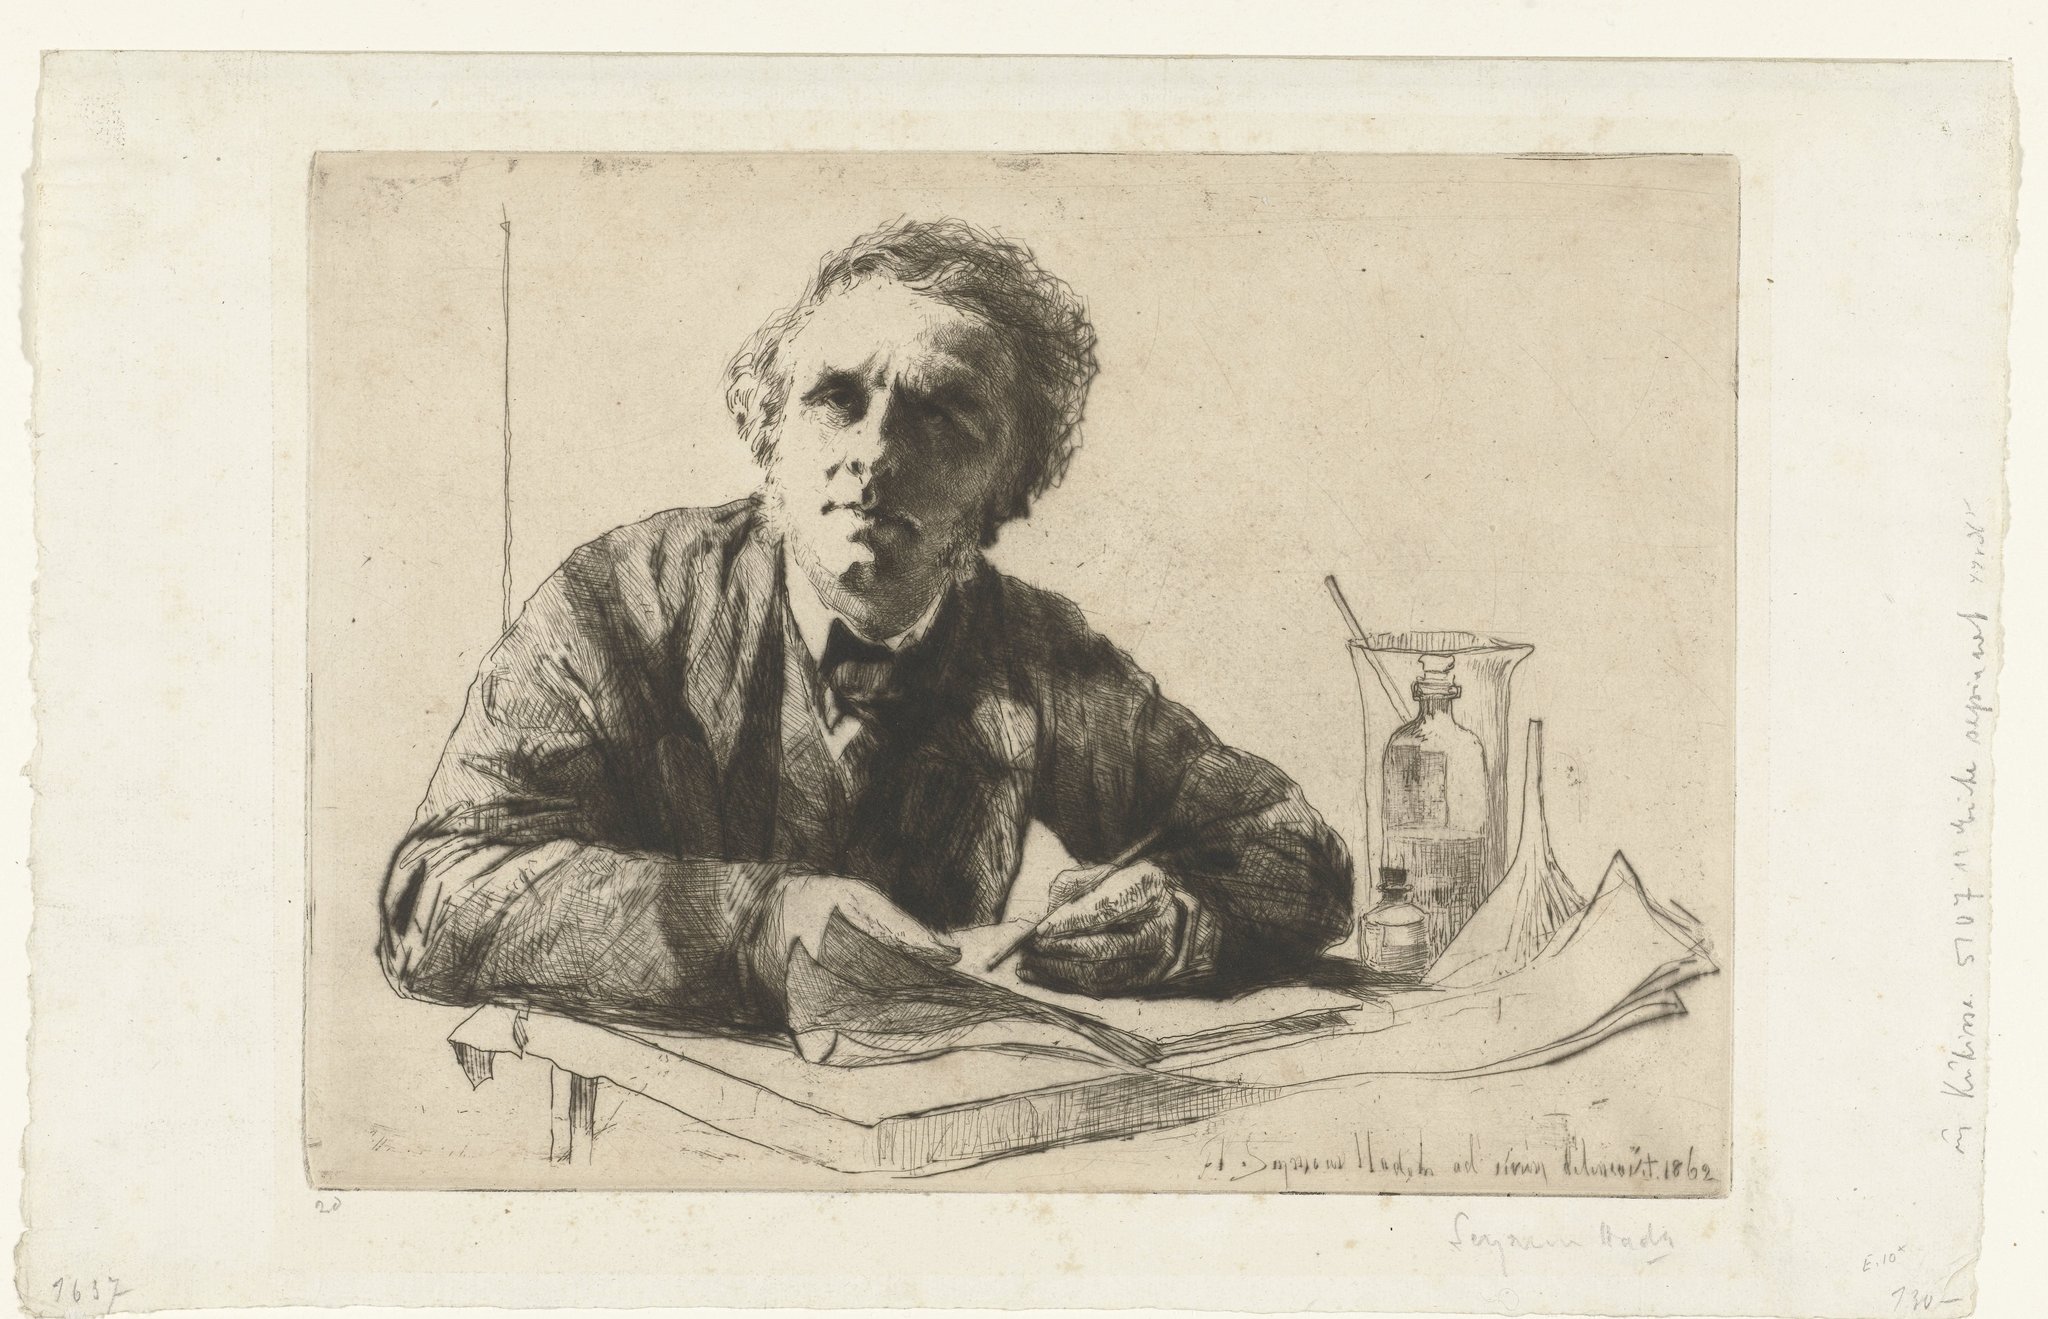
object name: print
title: Zelfportret van Francis Seymour-Haden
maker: francis seymour-haden (sir)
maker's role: print maker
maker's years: 1818-1910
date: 1862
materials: paper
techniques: drypoint, etching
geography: england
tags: print maker, francis seymour-haden (sir), portrait, self-portrait of artist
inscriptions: inscription: ‘Seymour Haden’, inscription: ‘Seymour Haden ad vivam delineavit 1862’, collector's mark: Lugt 2228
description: Zelfportret van de kunstenaar Francis Seymour-Haden, ten halven lijve, zittend aan een tafel met een pen in de hand. Op tafel liggen papieren en etsmaterialen.